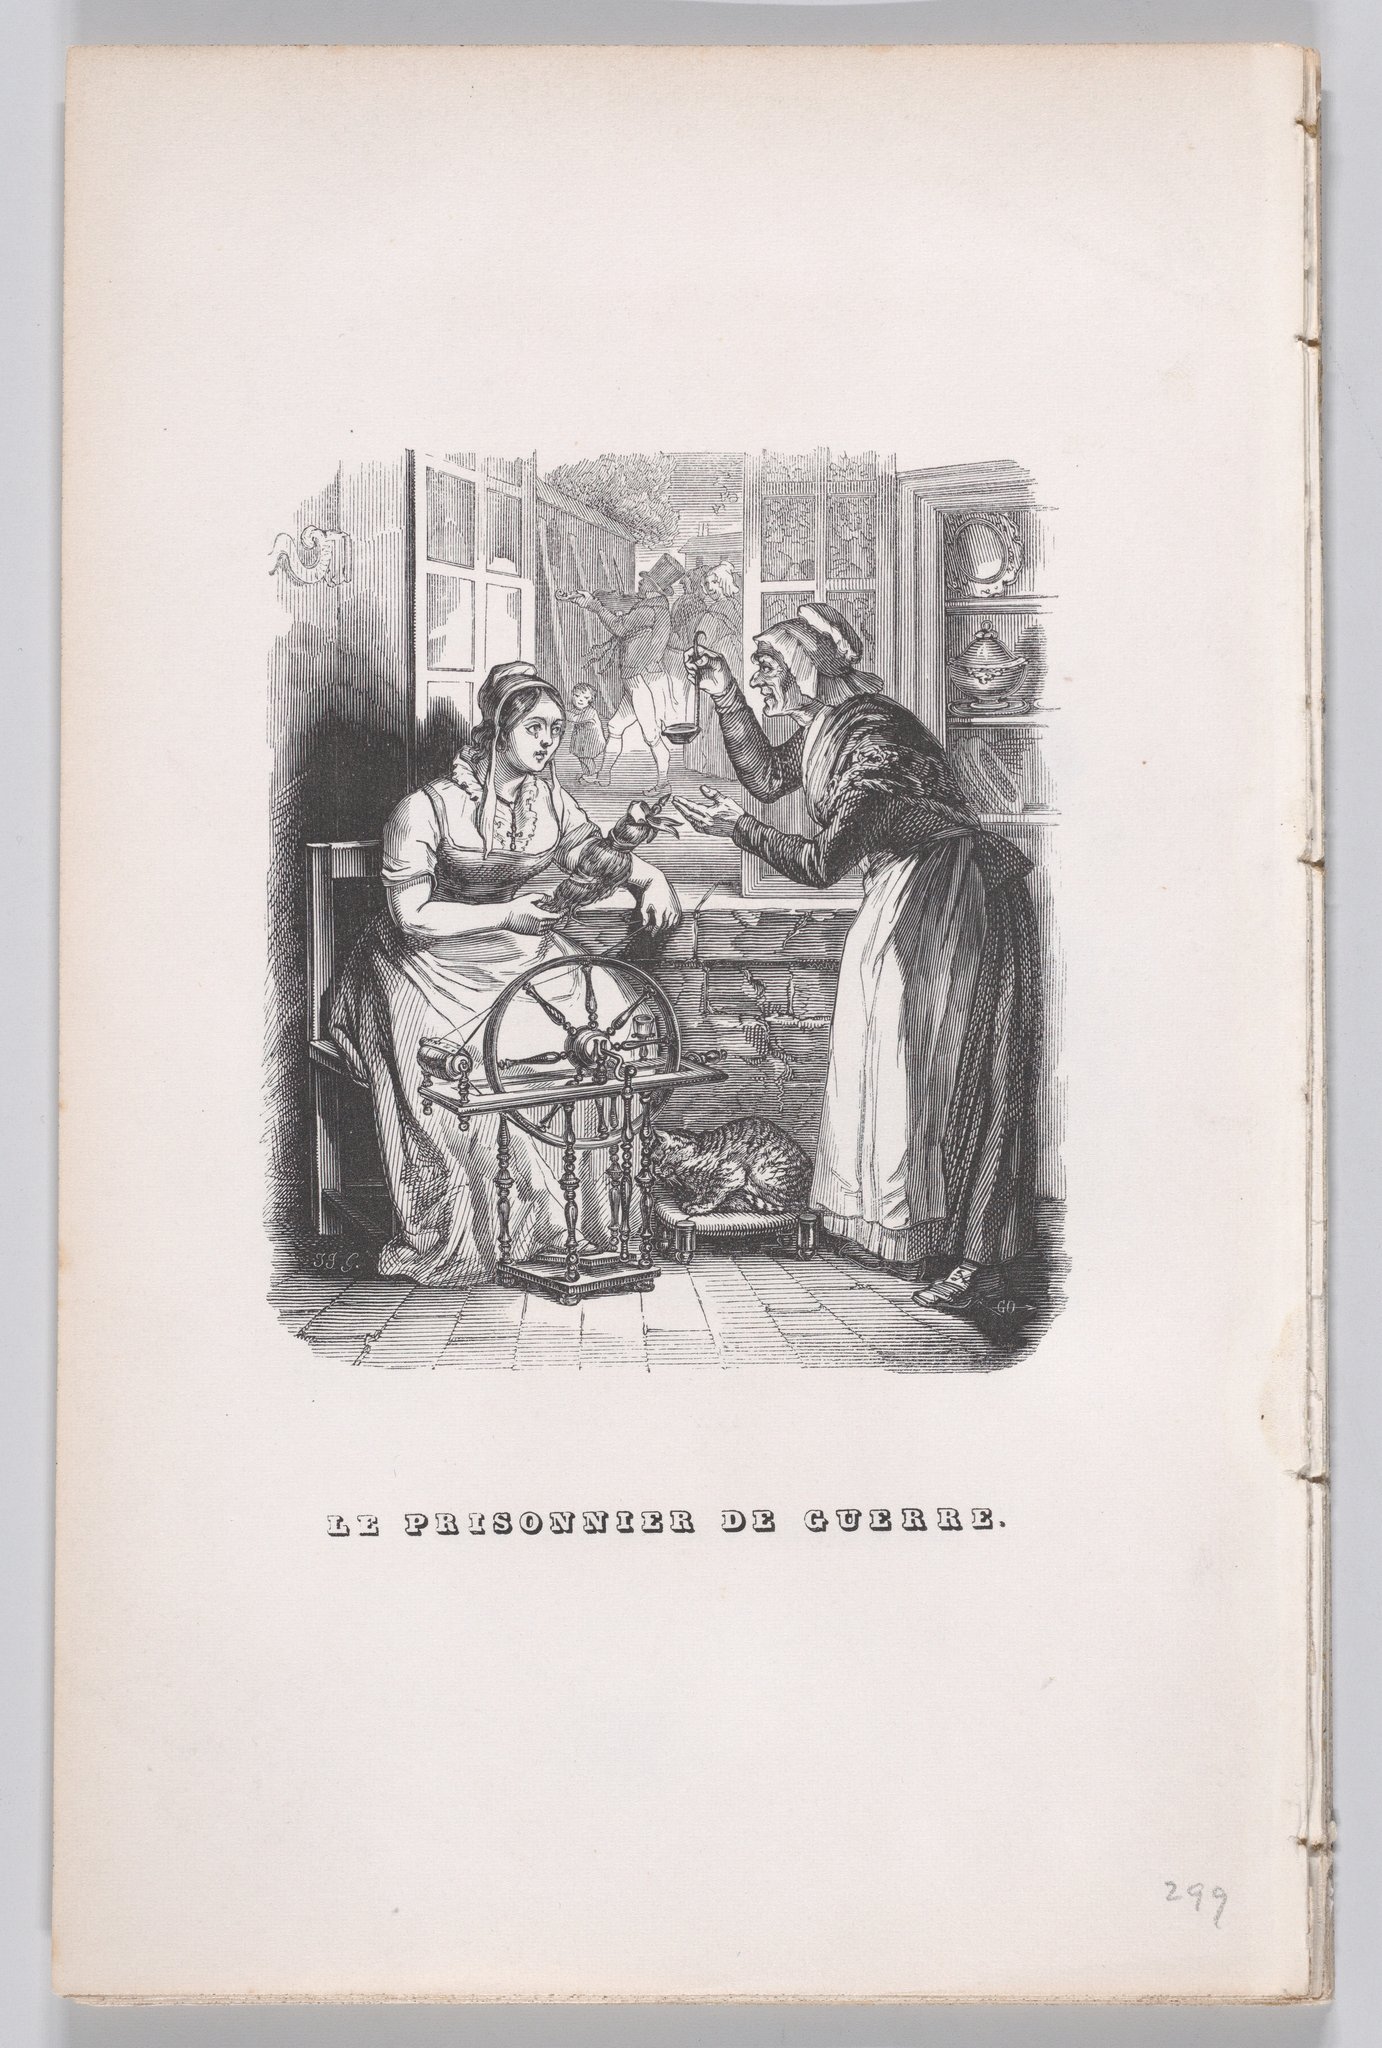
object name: print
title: The Prisoner of War, from "The Complete Works of Béranger"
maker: j. j. grandville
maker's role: artist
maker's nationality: french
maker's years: 1803-1847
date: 1836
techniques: engraving